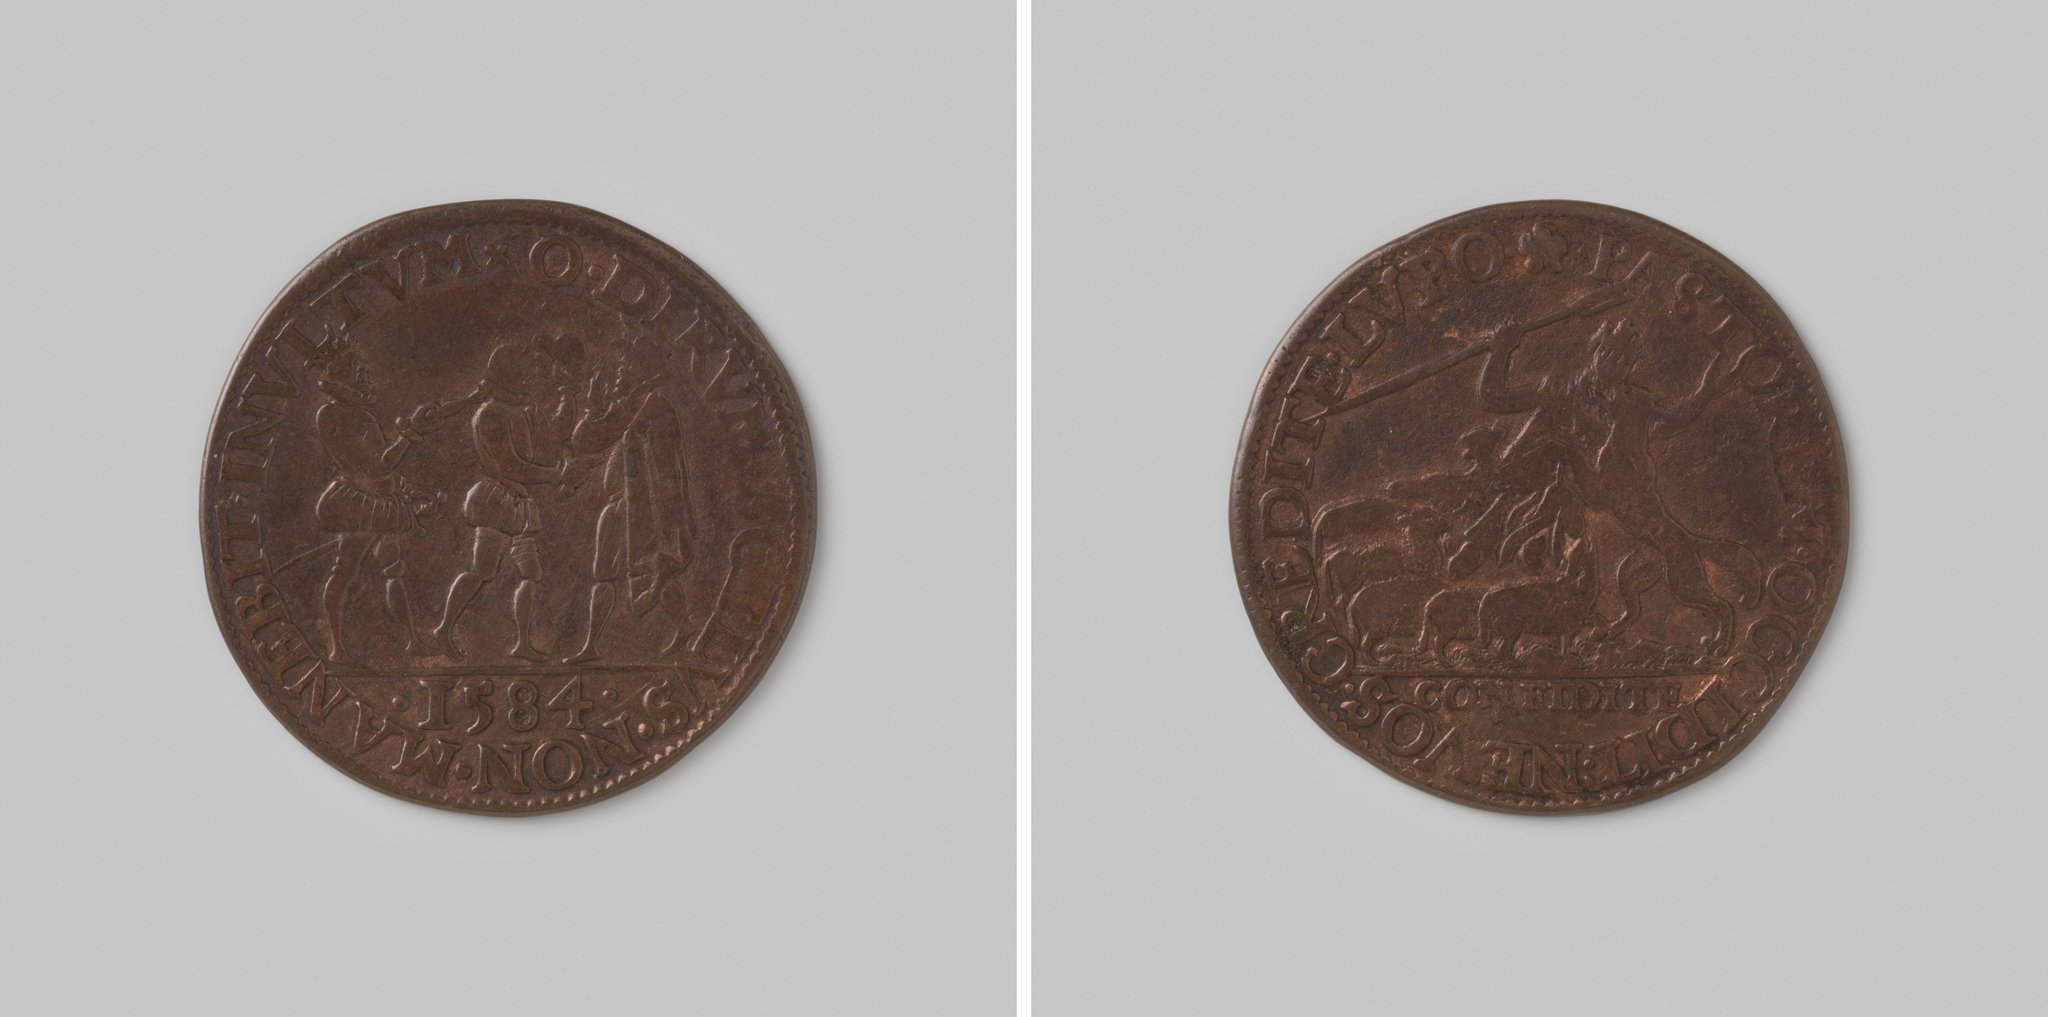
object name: jeton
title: Rekenpenning uit Dordrecht op de moord op Willem van Oranje door Balthazar Gerards 1584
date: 1584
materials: copper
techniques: striking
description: Koperen penning, op de voorzijde Gerards die op aanwijzing van Philips II Willem van Oranje neerschiet, met omschrift, op de keerzijde een wolf die een herder aanvalt te midden van diens kudde, met omschrift.